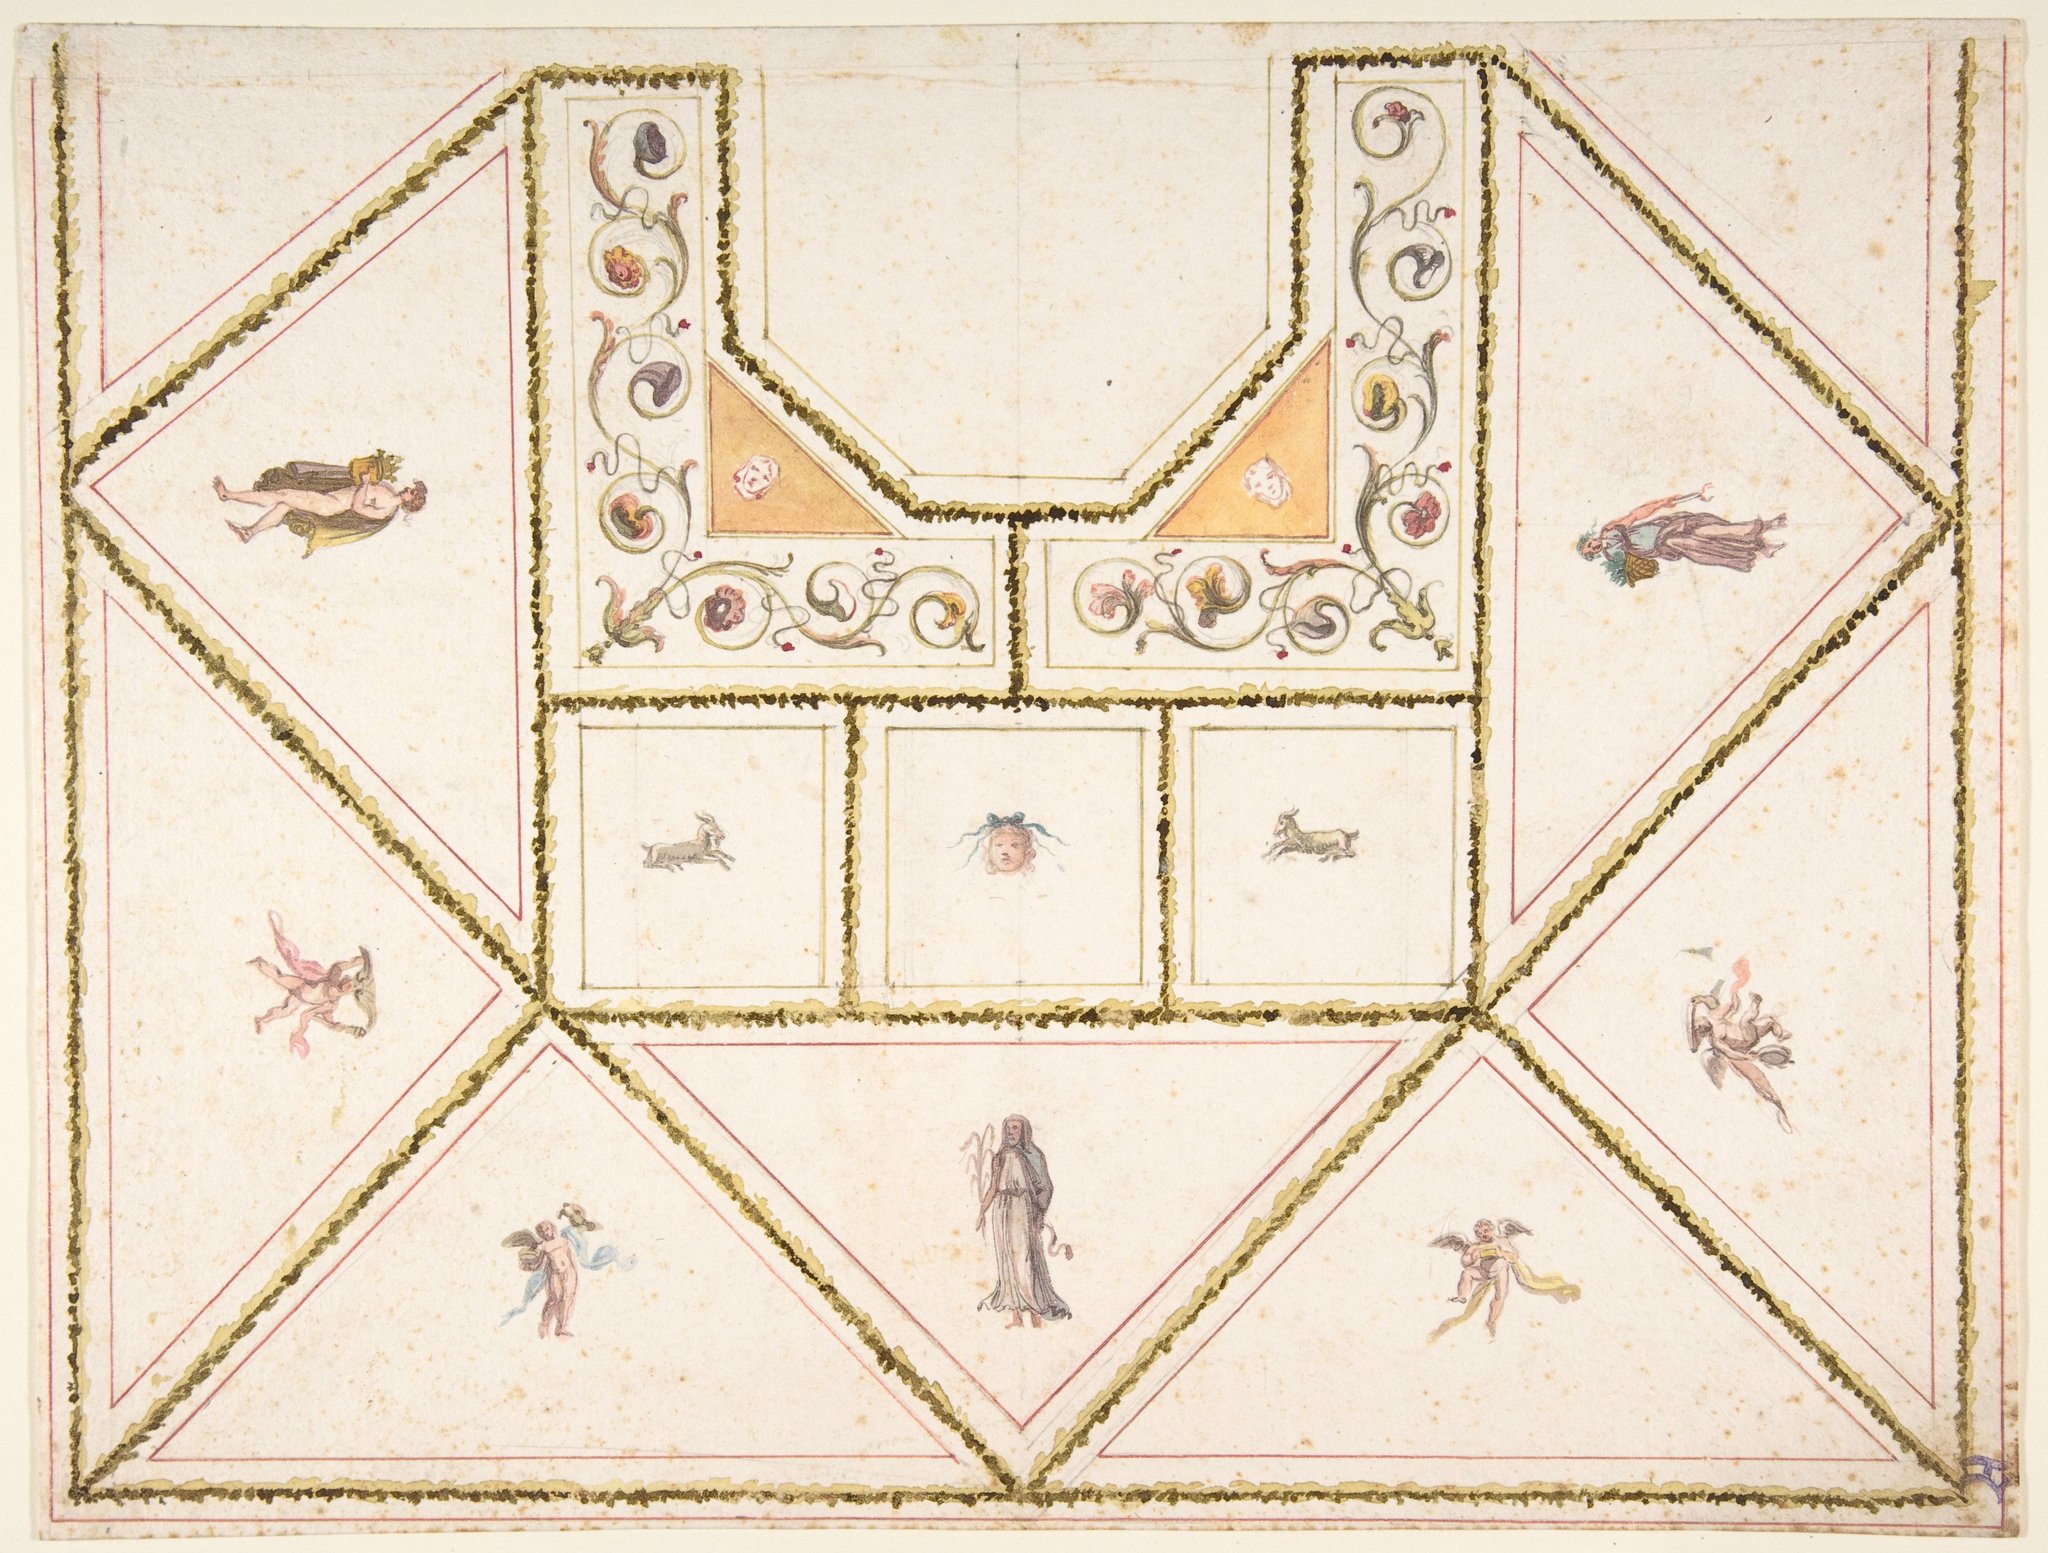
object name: drawing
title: Design for a Ceiling in Pompeian Style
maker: anonymous, italian, 18th century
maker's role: artist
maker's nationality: italian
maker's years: 1700-1800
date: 1701-1800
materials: graphite, ink, lead, watercolor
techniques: brush, pen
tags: heads,men,goats,flowers